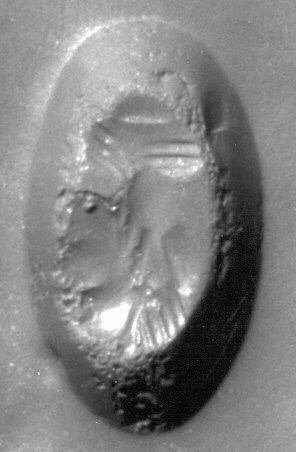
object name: stamp seal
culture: sasanian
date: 201-700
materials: gemstone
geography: iran